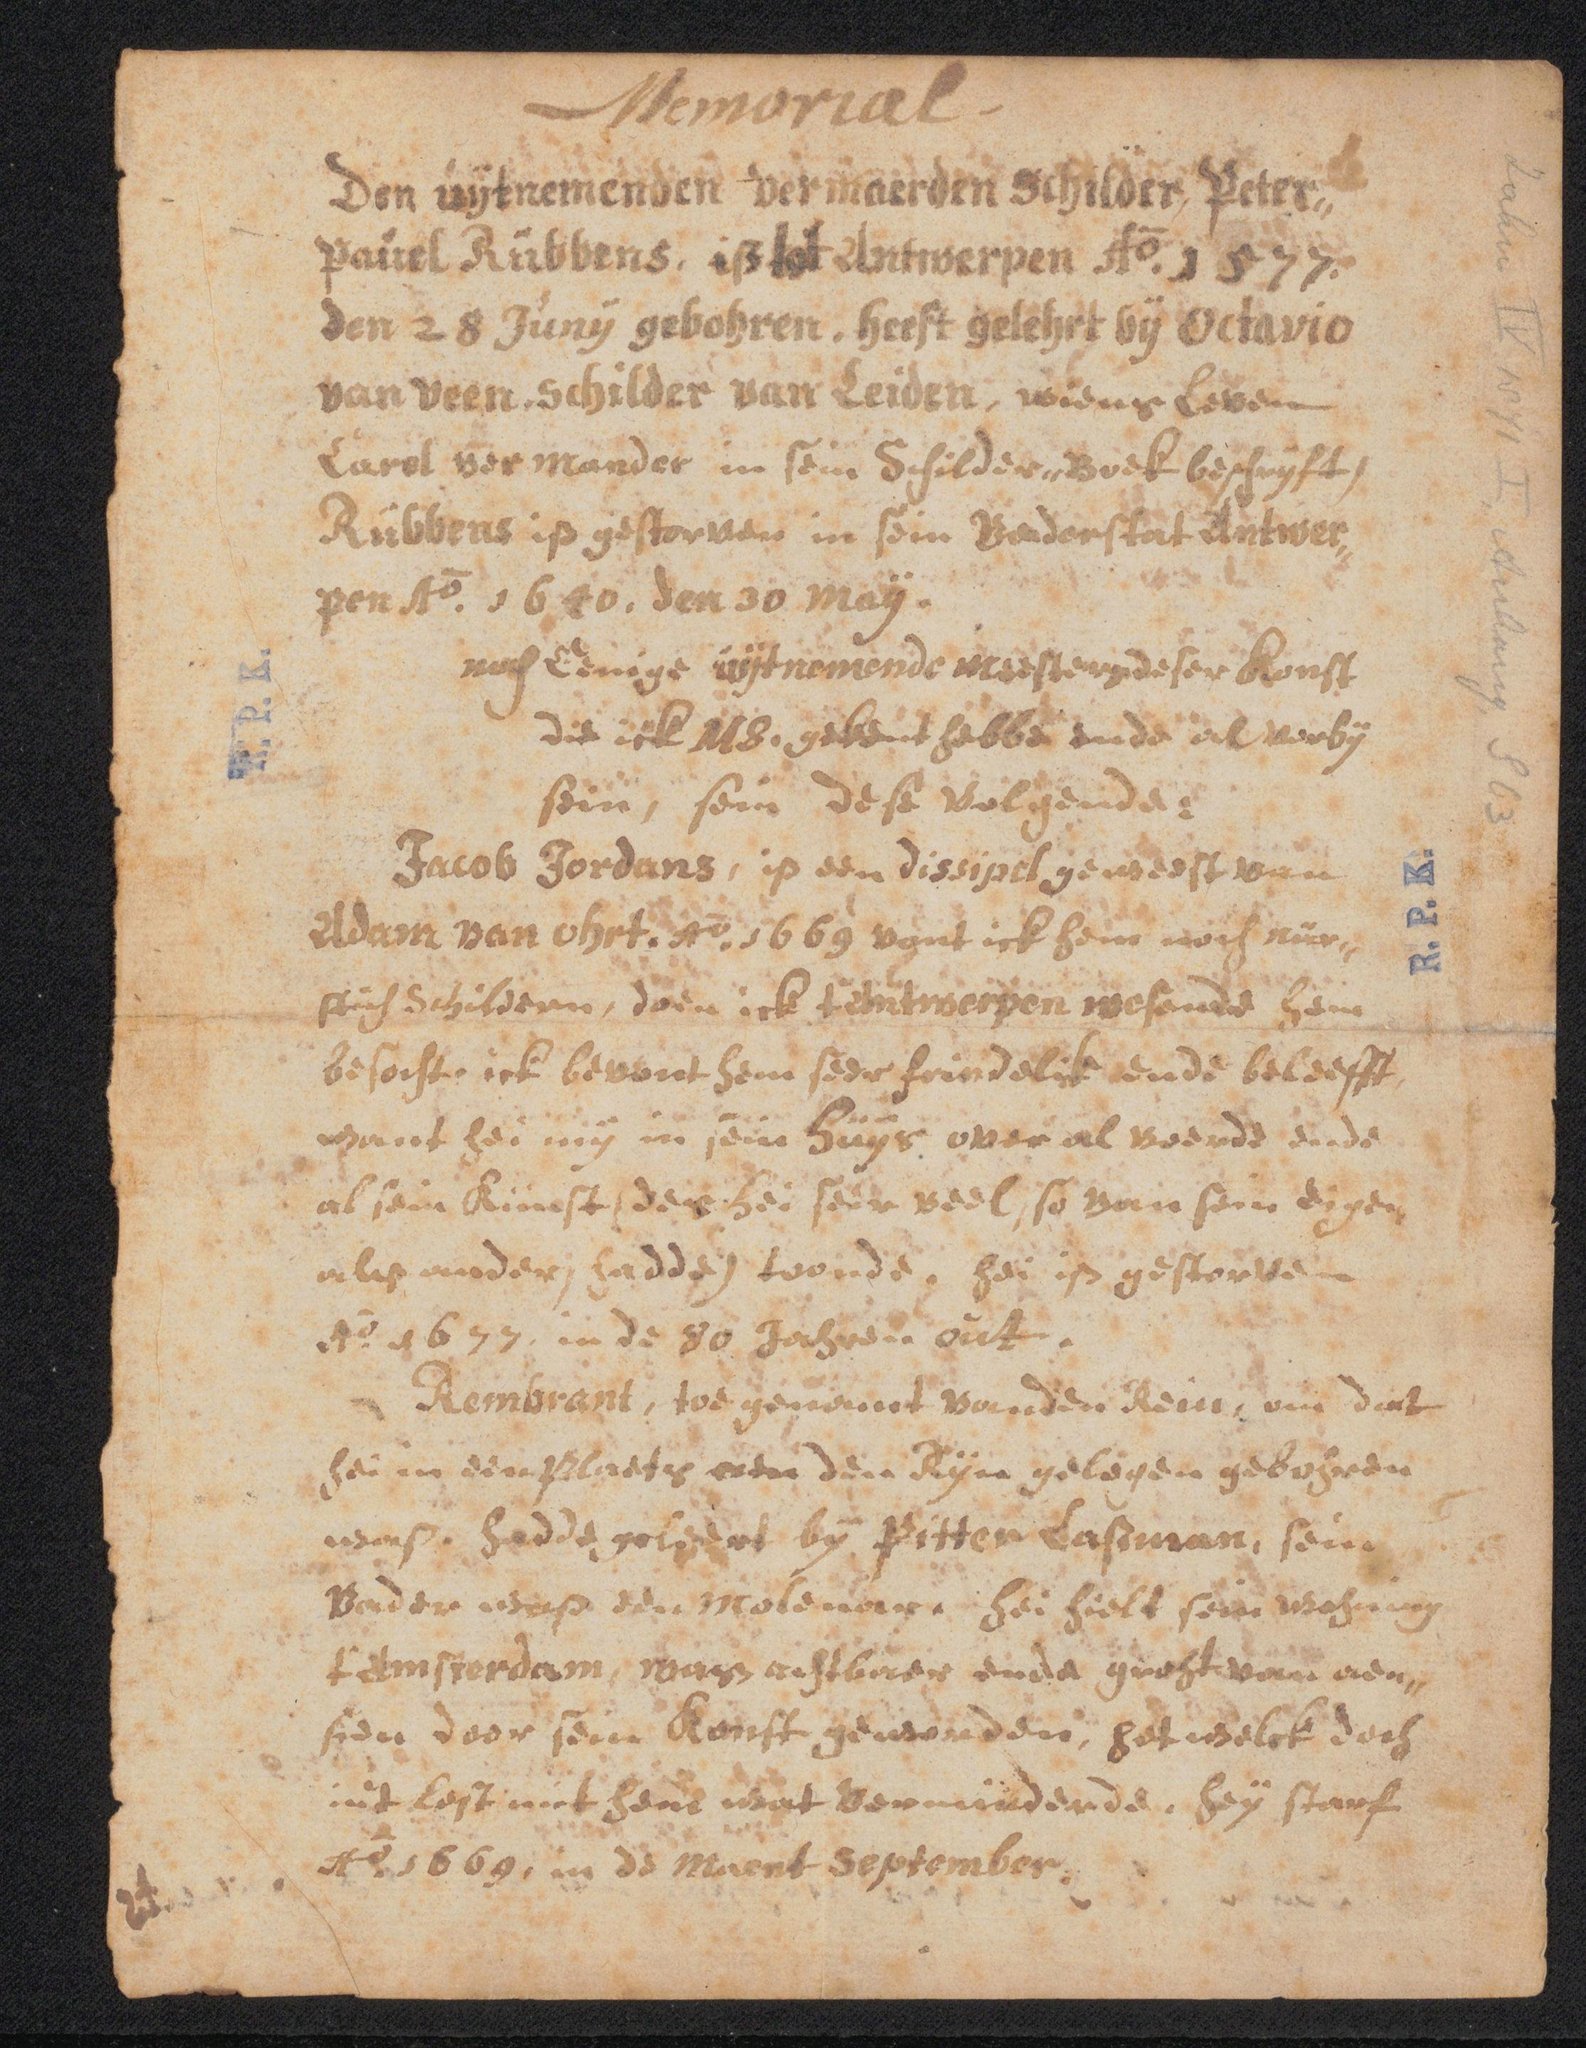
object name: aantekening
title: Aantekening betreffende Peter Paul Rubens, Jacques Jordaens en andere schilders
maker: matthias scheits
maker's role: print maker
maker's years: 1625-1700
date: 1679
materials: ink, paper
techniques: pen, writing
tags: karel van mander (i), adam van noort, philips wouwerman, antwerp, painter, print maker, draughtsman, designer, jacques jordaens, haarlem, frans hals, leiden, rembrandt van rijn, peter paul rubens, amsterdam, pieter lastman, education, tuition of the artist (in general), painting (including book-illumination, miniature-painting)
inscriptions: collector's mark: Lugt 2233